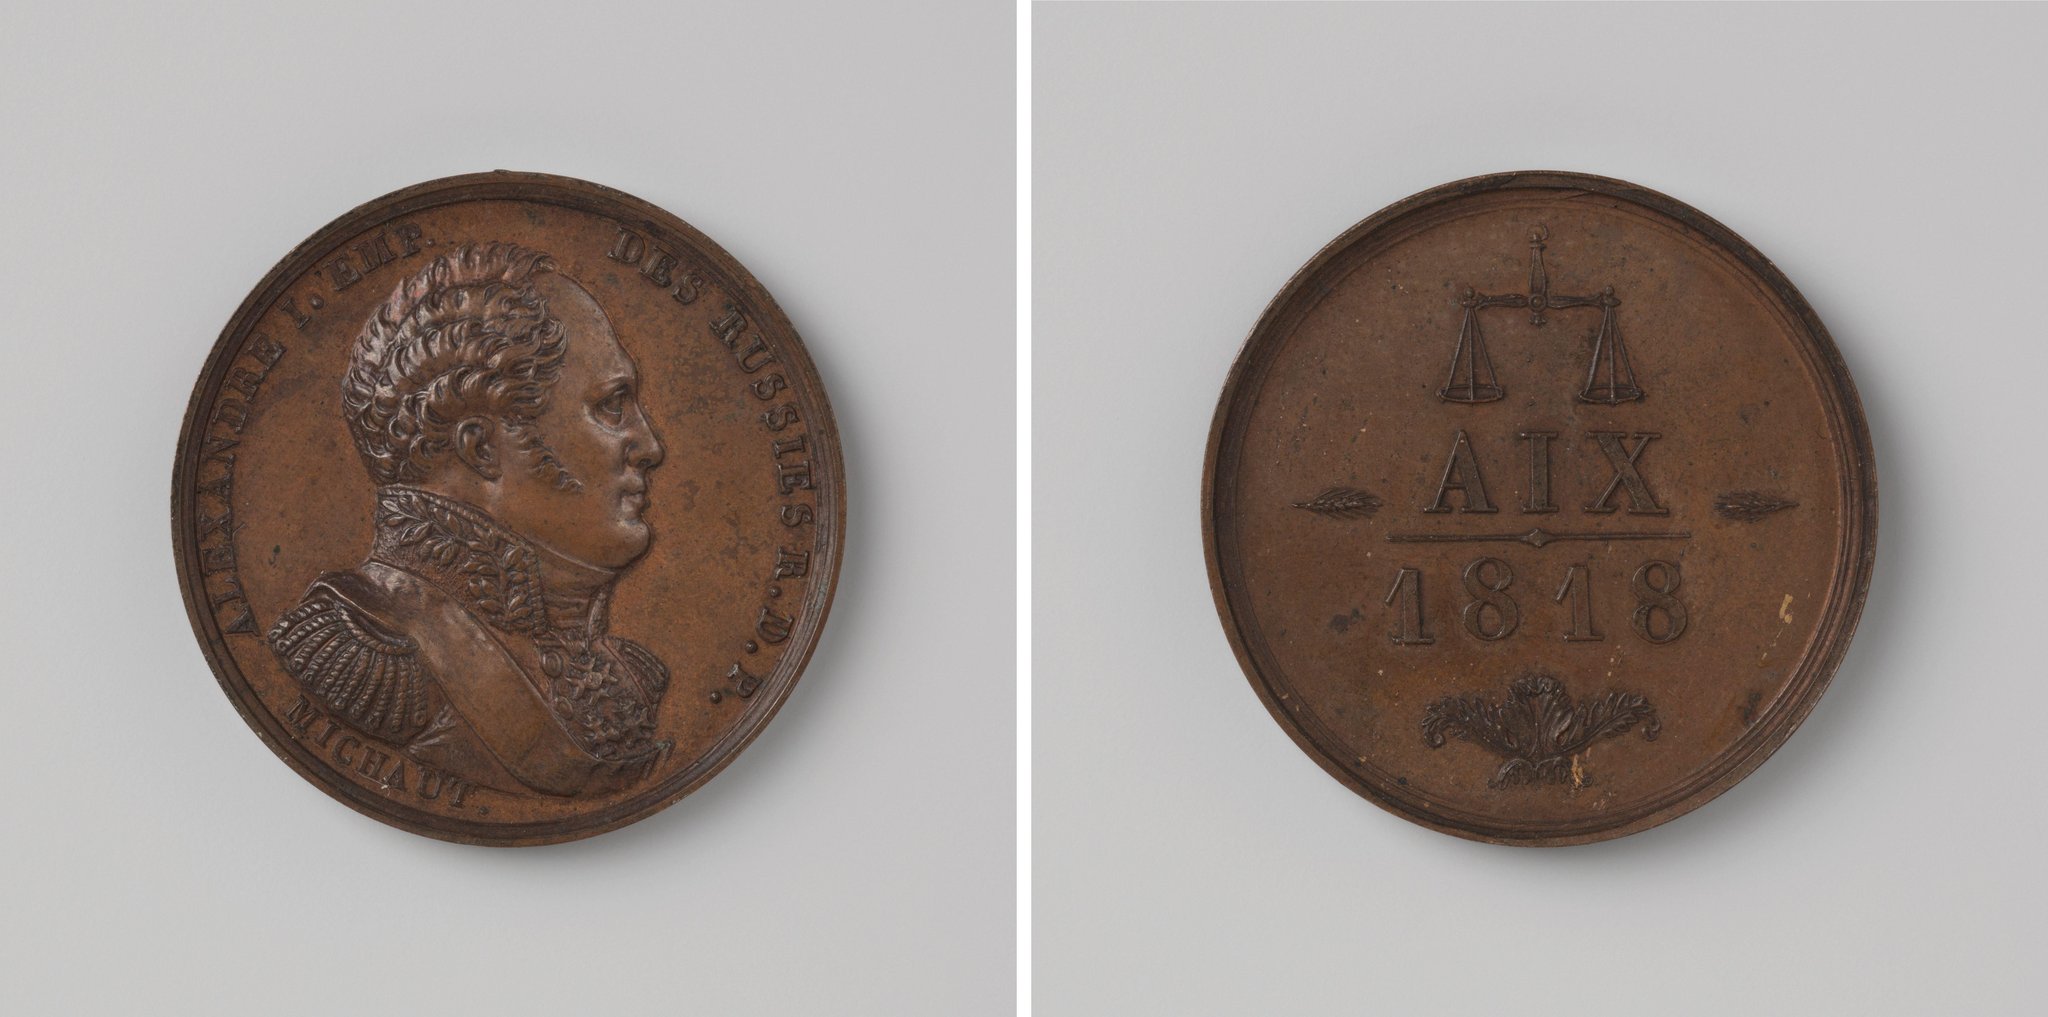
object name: history medal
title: Congres van Aken, ter ere van Alexander I, tsaar van Rusland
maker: auguste francois michaut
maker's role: sculptor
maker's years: 1786-1879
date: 1818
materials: bronze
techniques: striking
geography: netherlands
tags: alexander i (tsaar van rusland)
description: Bronzen penning. Voorzijde: borststuk man binnen omschrift. Keerzijde: opschrift onder weegschaal in evenwicht tussen siermotieven